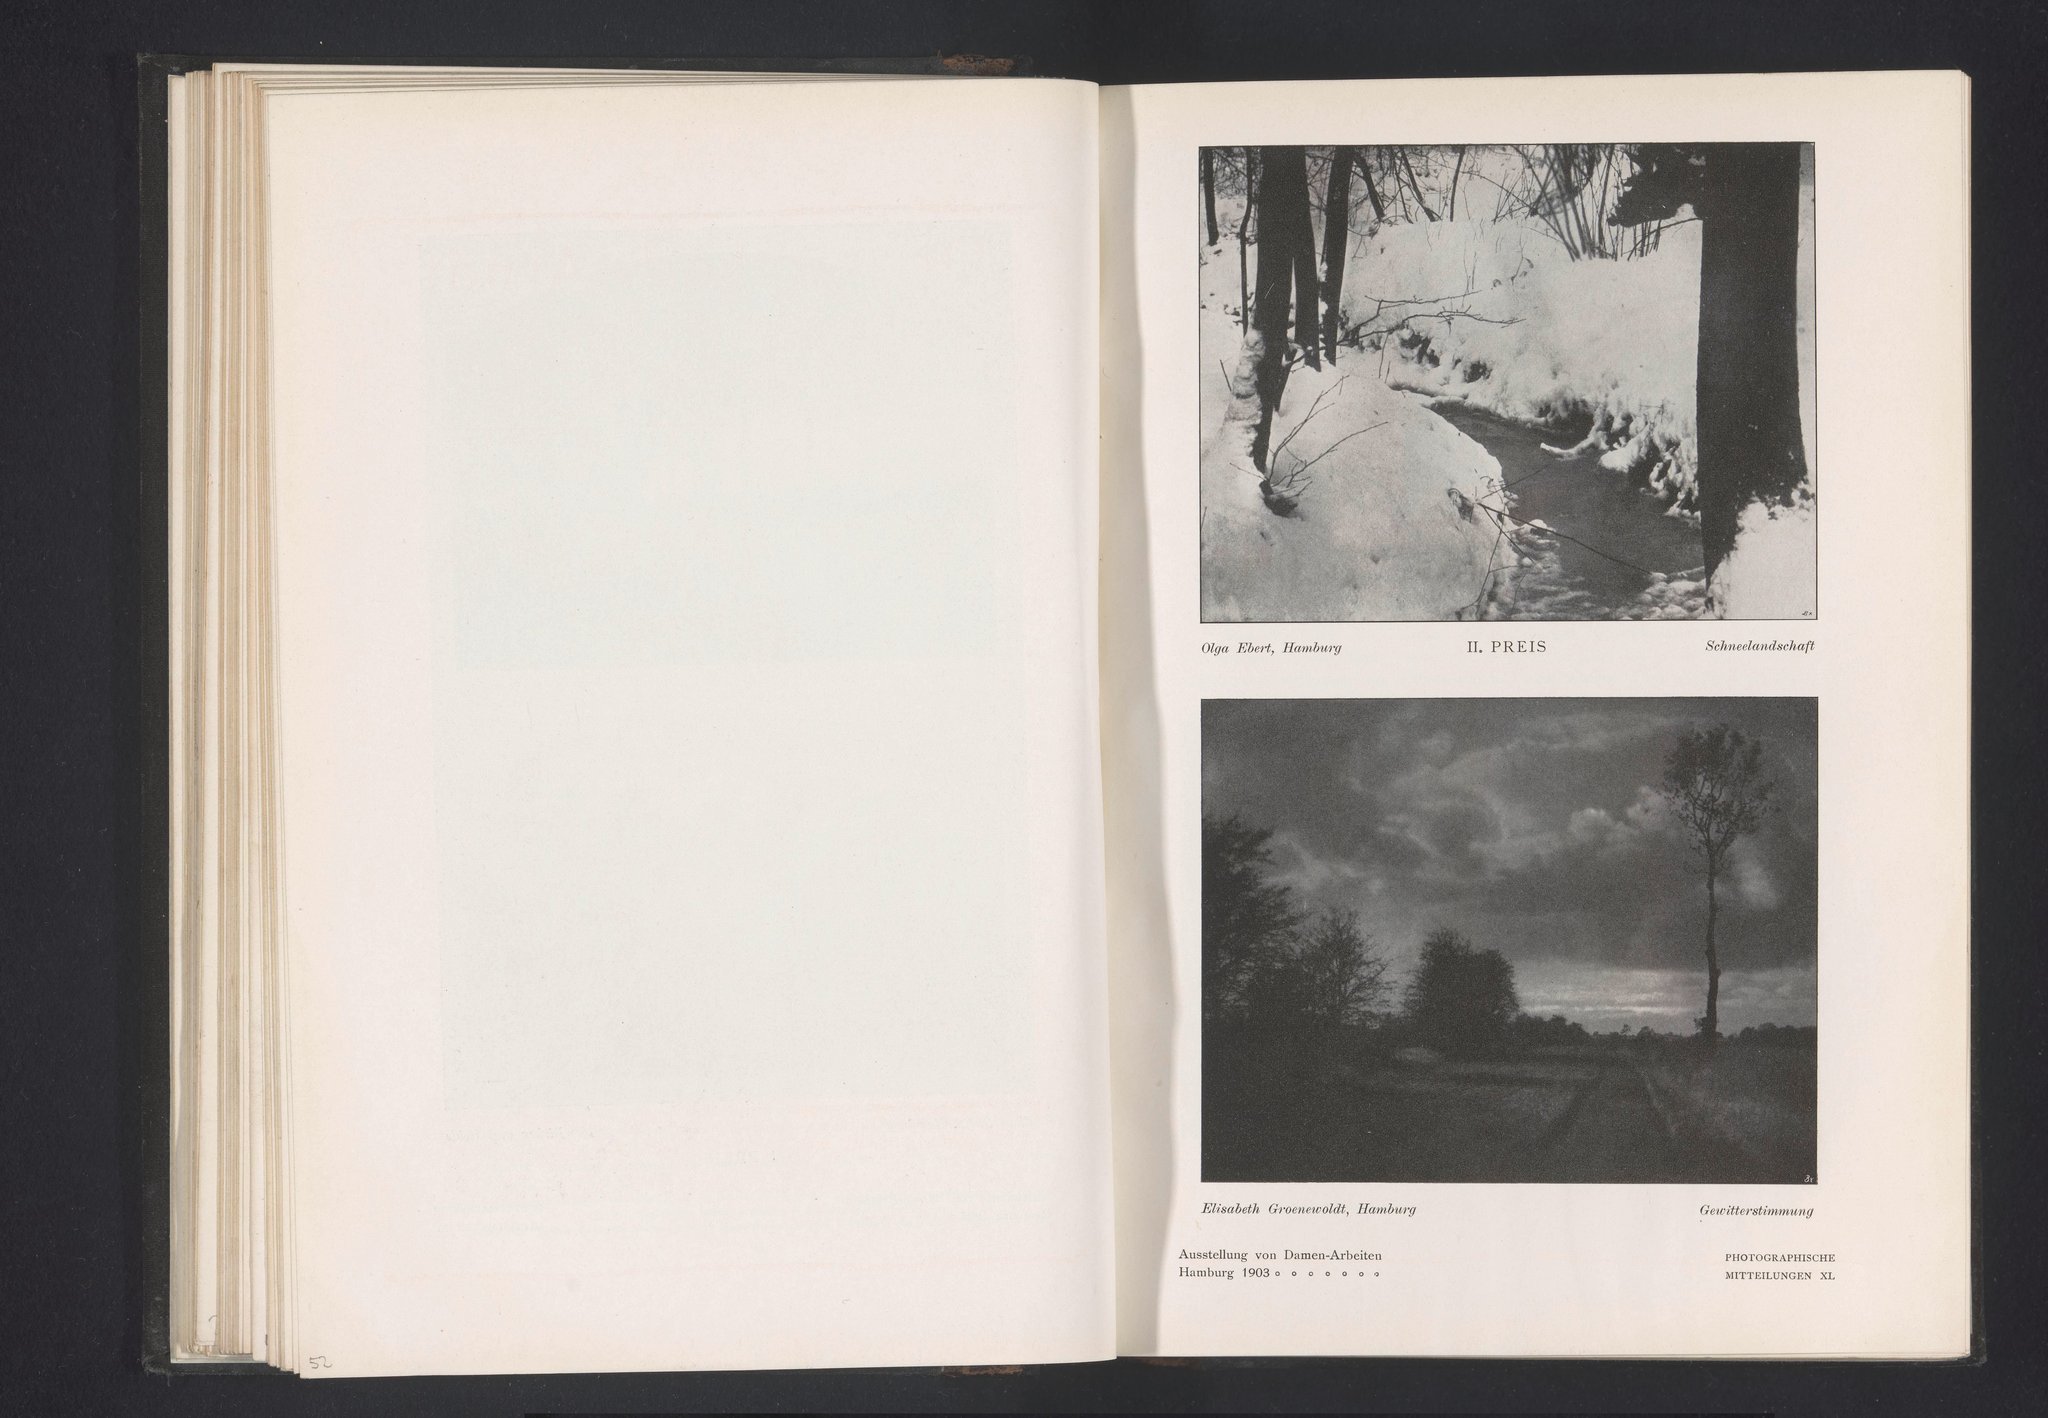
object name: photomechanical print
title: Gewitterstimmung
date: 1898-1903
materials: paper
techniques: autotype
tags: landscapes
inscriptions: inscription: ‘Ausstellung von Damen-Arbeiten Hamburg 1903/ Photographische Mitteilungen XL’, monogram: ‘BX’, inscription: ‘Hamburg’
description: Prent op derde ongenummerde pagina na pagina 82.